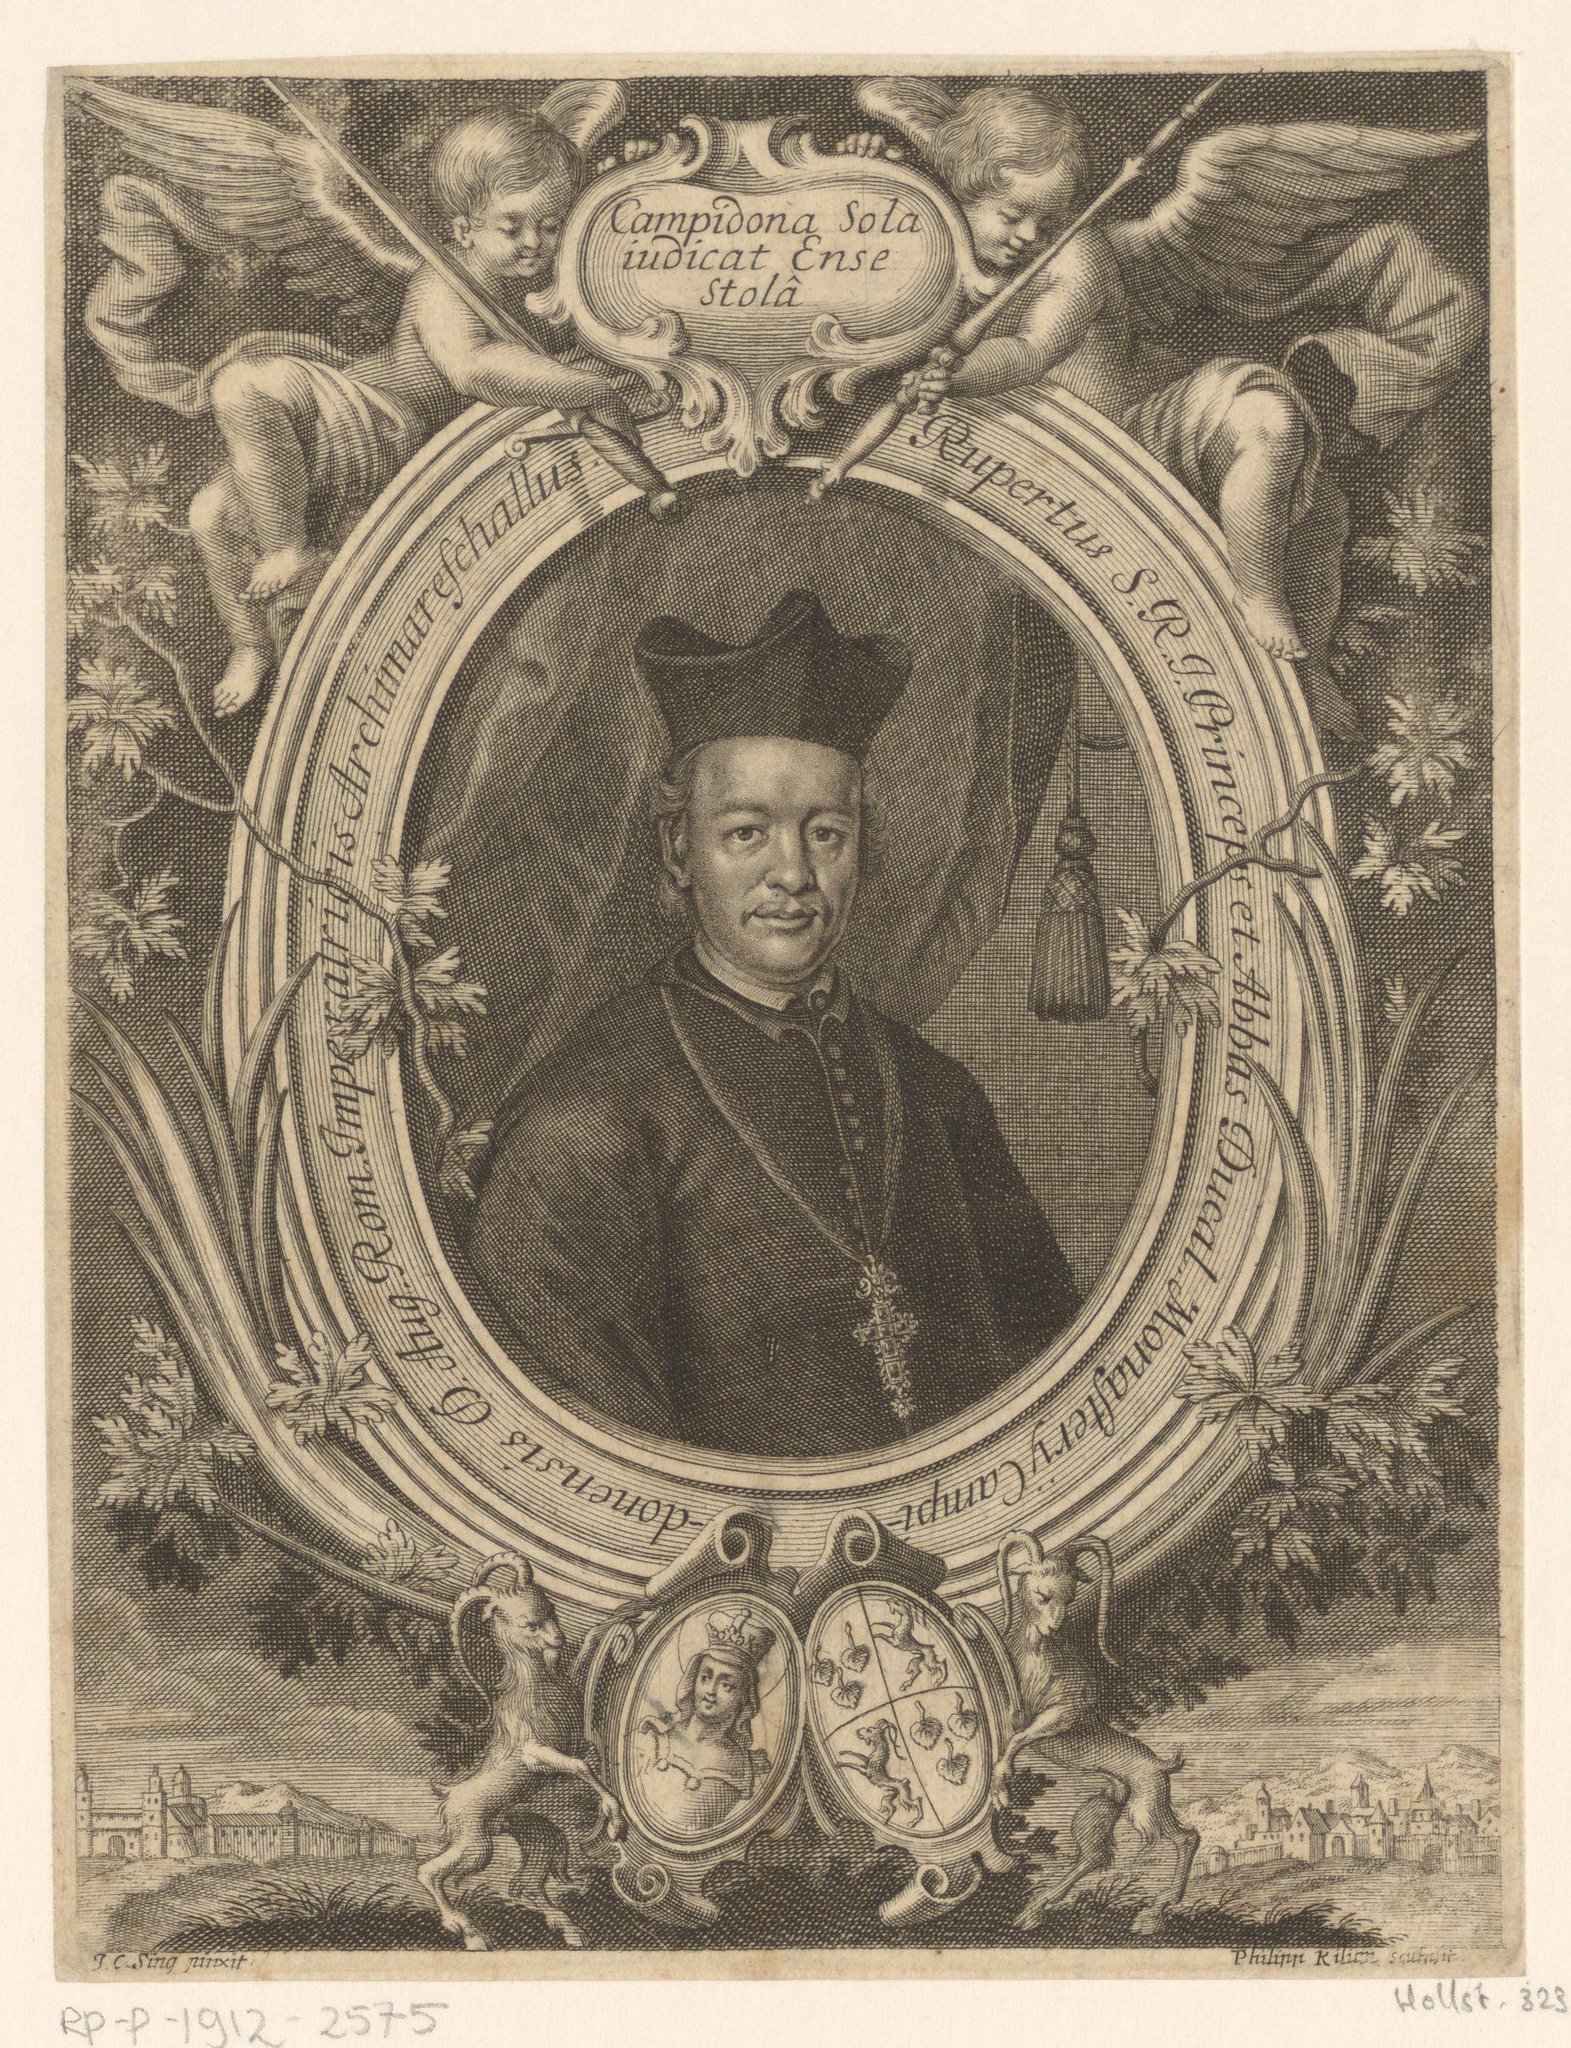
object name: print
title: Portret van Rupert von Bodman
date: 1656-1693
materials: paper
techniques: engraving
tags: theologian, historical persons, ornament ~ festoon, garland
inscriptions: collector's mark: Lugt 2228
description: Tekst in het Latijn in de omlijsting. Twee putti, bokken en planten om het portretmedaillon, onderaan twee stadsgezichten.